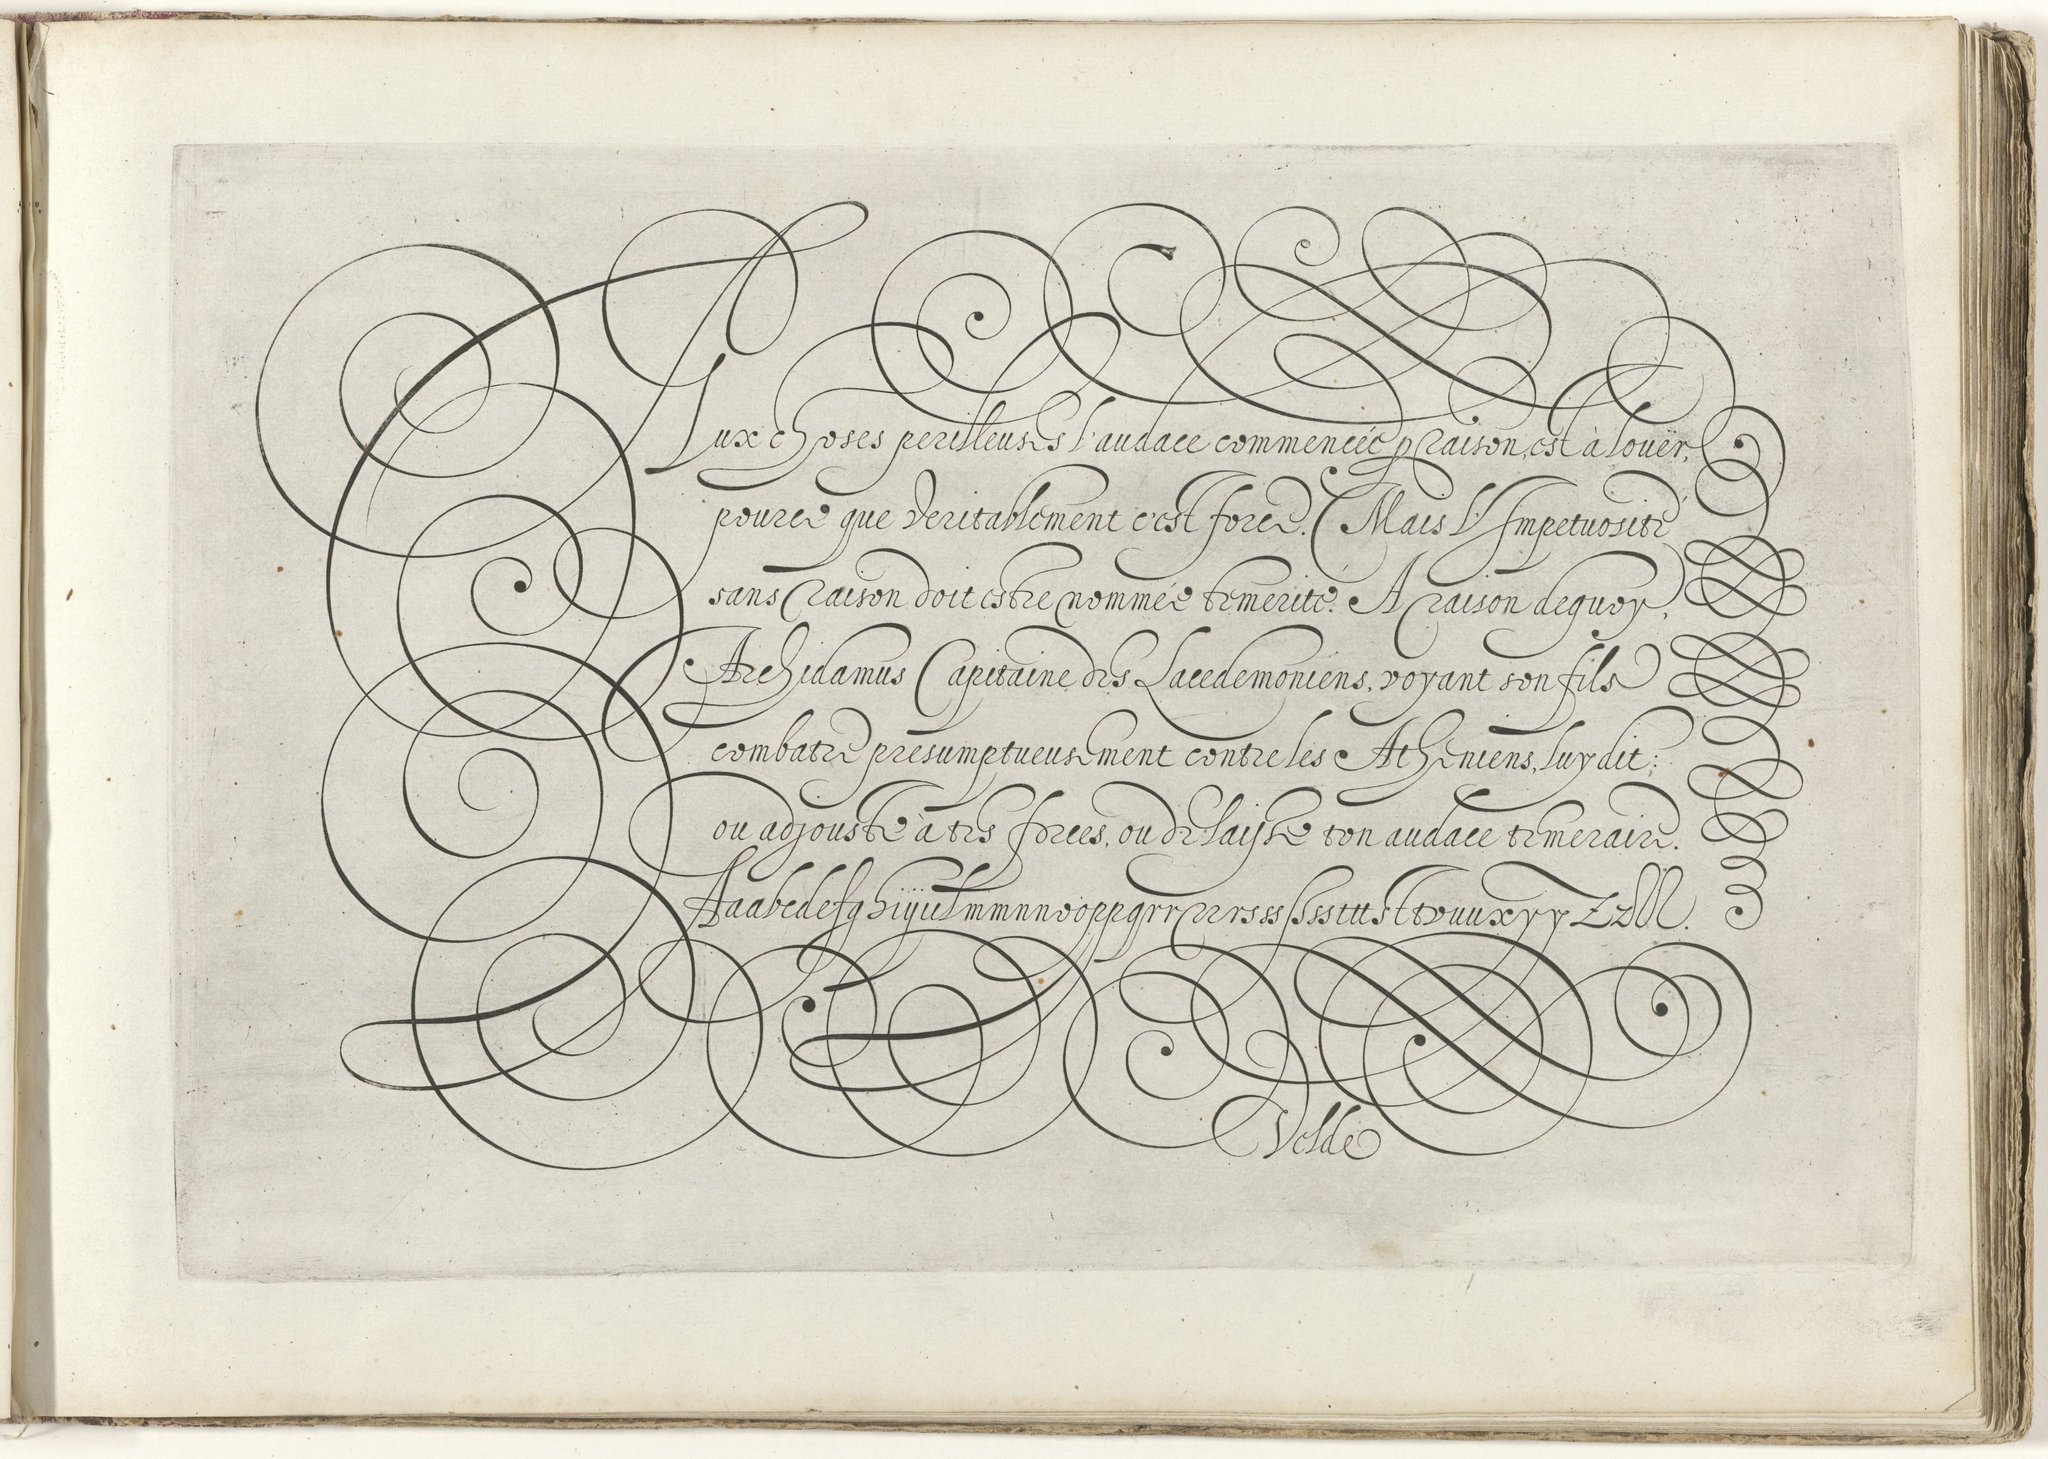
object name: album leaf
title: Spieghel der schrijfkonste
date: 1605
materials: paper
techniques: engraving, intaglio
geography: amsterdam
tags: calligraphy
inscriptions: collector's mark: Lugt 2228, collector's mark: Lugt 2760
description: Schrijfvoorbeeld met zeven regels tekst in het Frans: Lux choses perilleuses ... De tekst is omlijst met krulwerk. De prent maakt deel uit van een album.